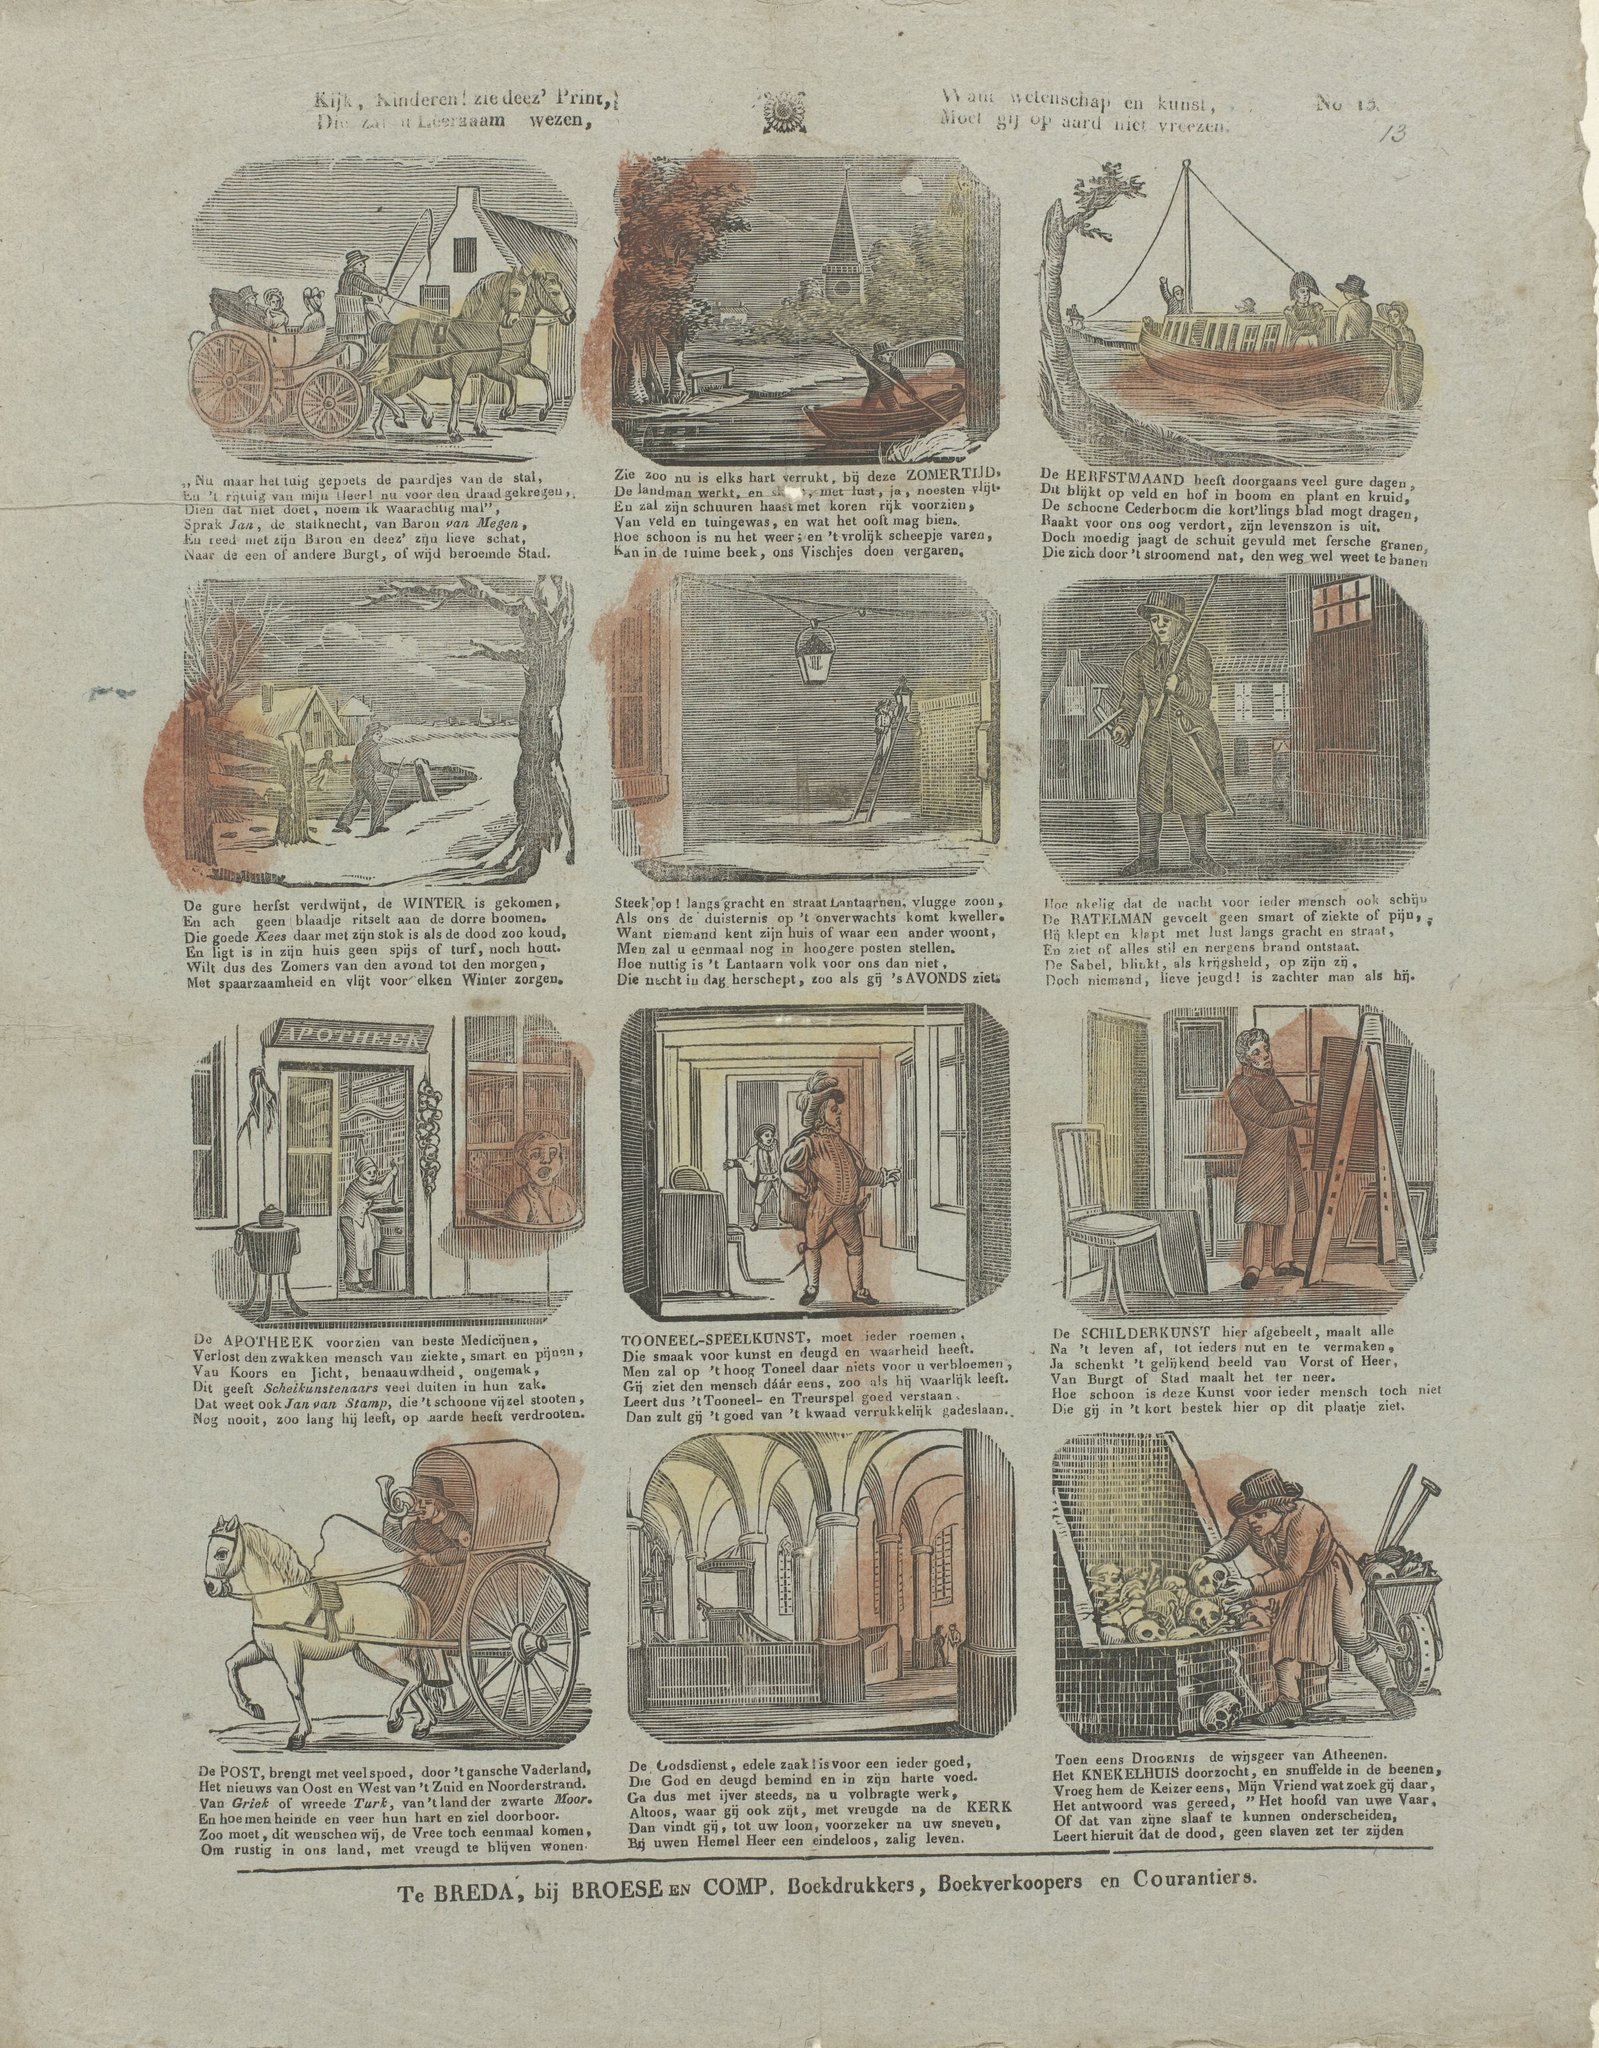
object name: print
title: Kijk kinderen! zie deez' print, / Die zal u leerzaam wezen, / Want wetenschap en kunst, / Moet gij op aard niet vrezen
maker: Anonymous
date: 1828-1853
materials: paper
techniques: colour, letterpress printing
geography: breda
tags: art, time, day and night, the four seasons of the year ~ human activities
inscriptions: collector's mark: Lugt 2760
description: Blad met 12 verschillende figuren en taferelen, die onder andere uitbeelden: zomertijd, herfstmaand, avond en schilderkunst. Onder elke voorstelling een zesregelig vers. Genummerd rechtsboven: No. 13.